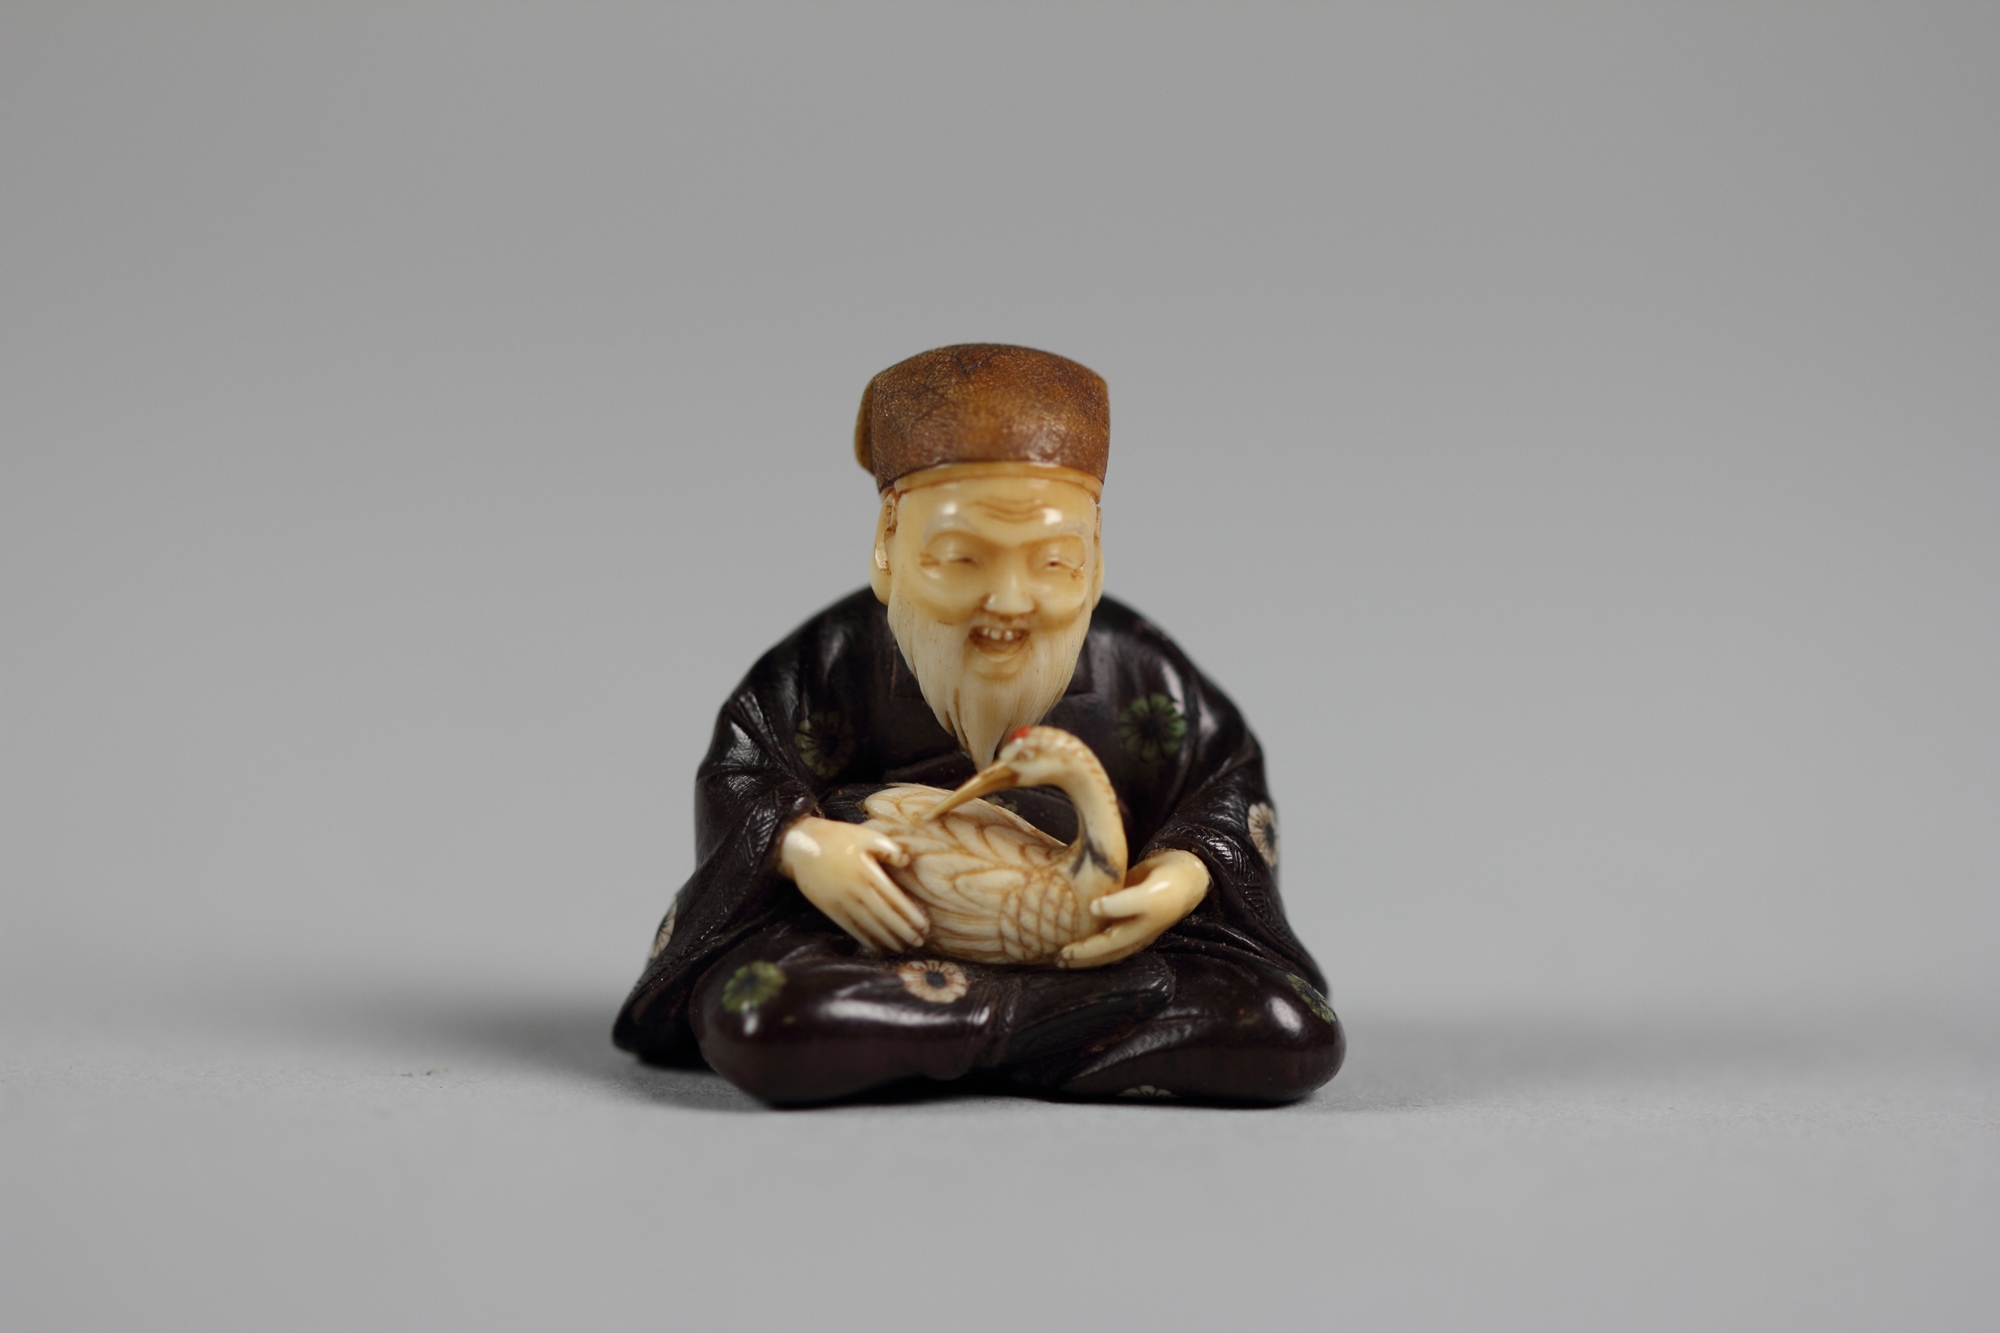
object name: netsuke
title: Netsuke of Jurōjin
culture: japanese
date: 1801-1900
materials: ivory, wood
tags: men